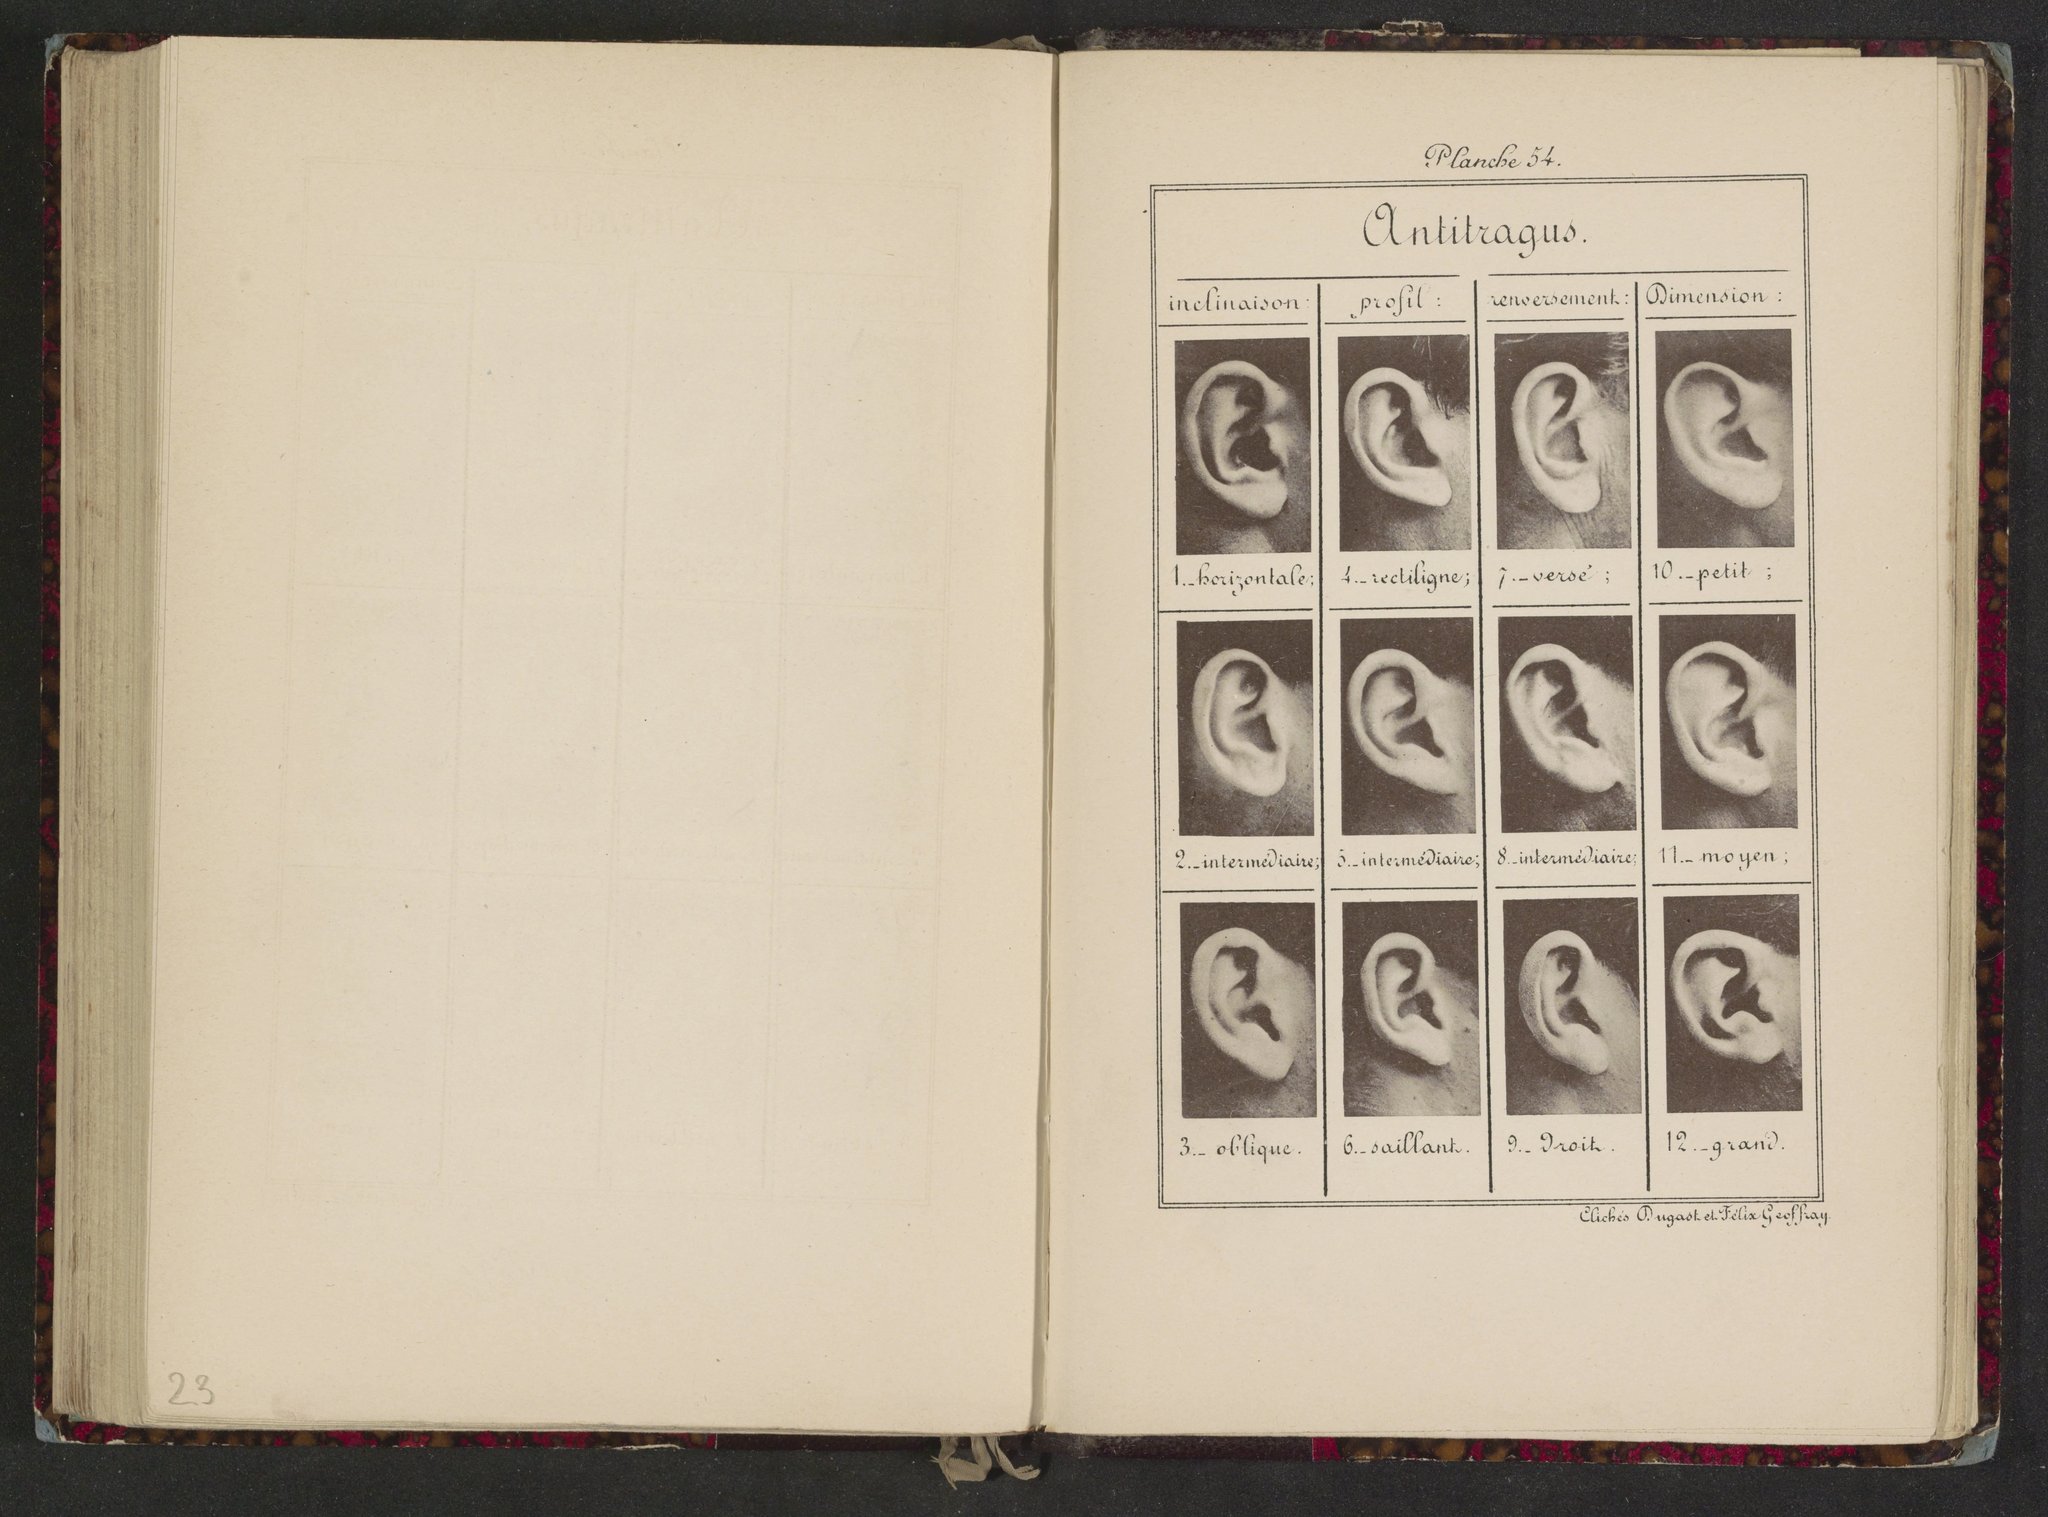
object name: photomechanical print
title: Antitragus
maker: Anonymous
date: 1880-1893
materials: paper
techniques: photograph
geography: france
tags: ears, france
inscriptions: number: ‘Planche 54.’, number: ‘1. (...) 12.’, inscription: ‘inclinaison : horizontale ; intermédiaire ; oblique. (...) Dimension : petit ; moyen ; grand.’